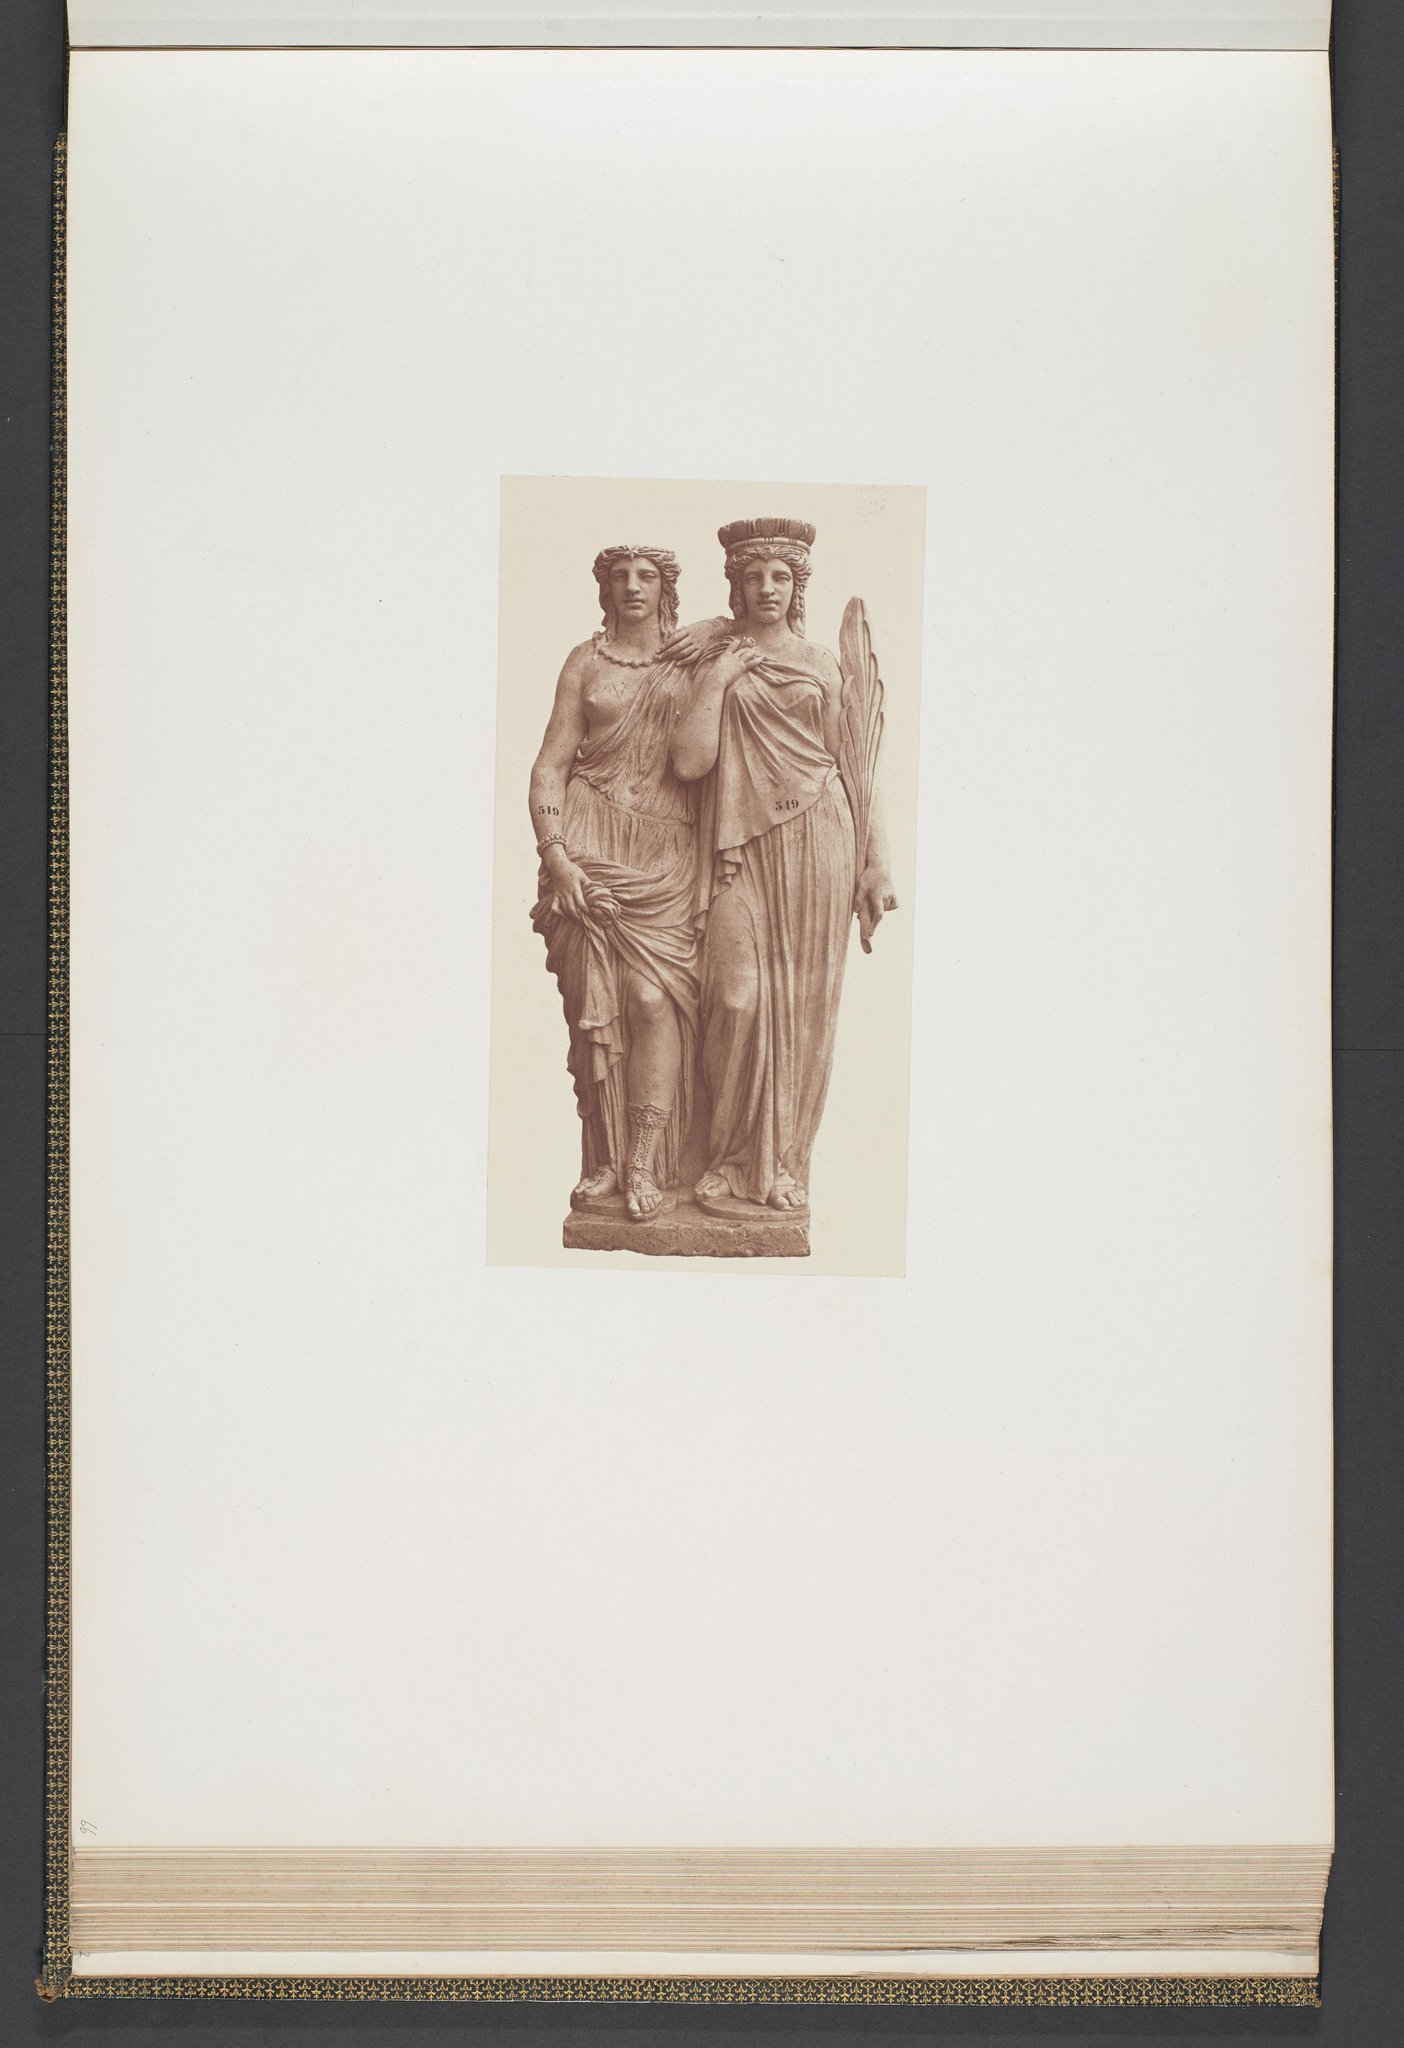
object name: album leaf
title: Gipsmodellen voor kariatiden op het Palais du Louvre door Georges Jacquot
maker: édouard denis baldus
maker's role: fotograaf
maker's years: 1813-1889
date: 1855-1857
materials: paper, photographic support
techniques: salted paper print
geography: paris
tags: caryatids ~ architecture, permanent exhibition, museum, paris, tuileries palace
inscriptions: number: ‘519’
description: Onderdeel van Réunion des Tuileries au Louvre 1852-1857, album 2.